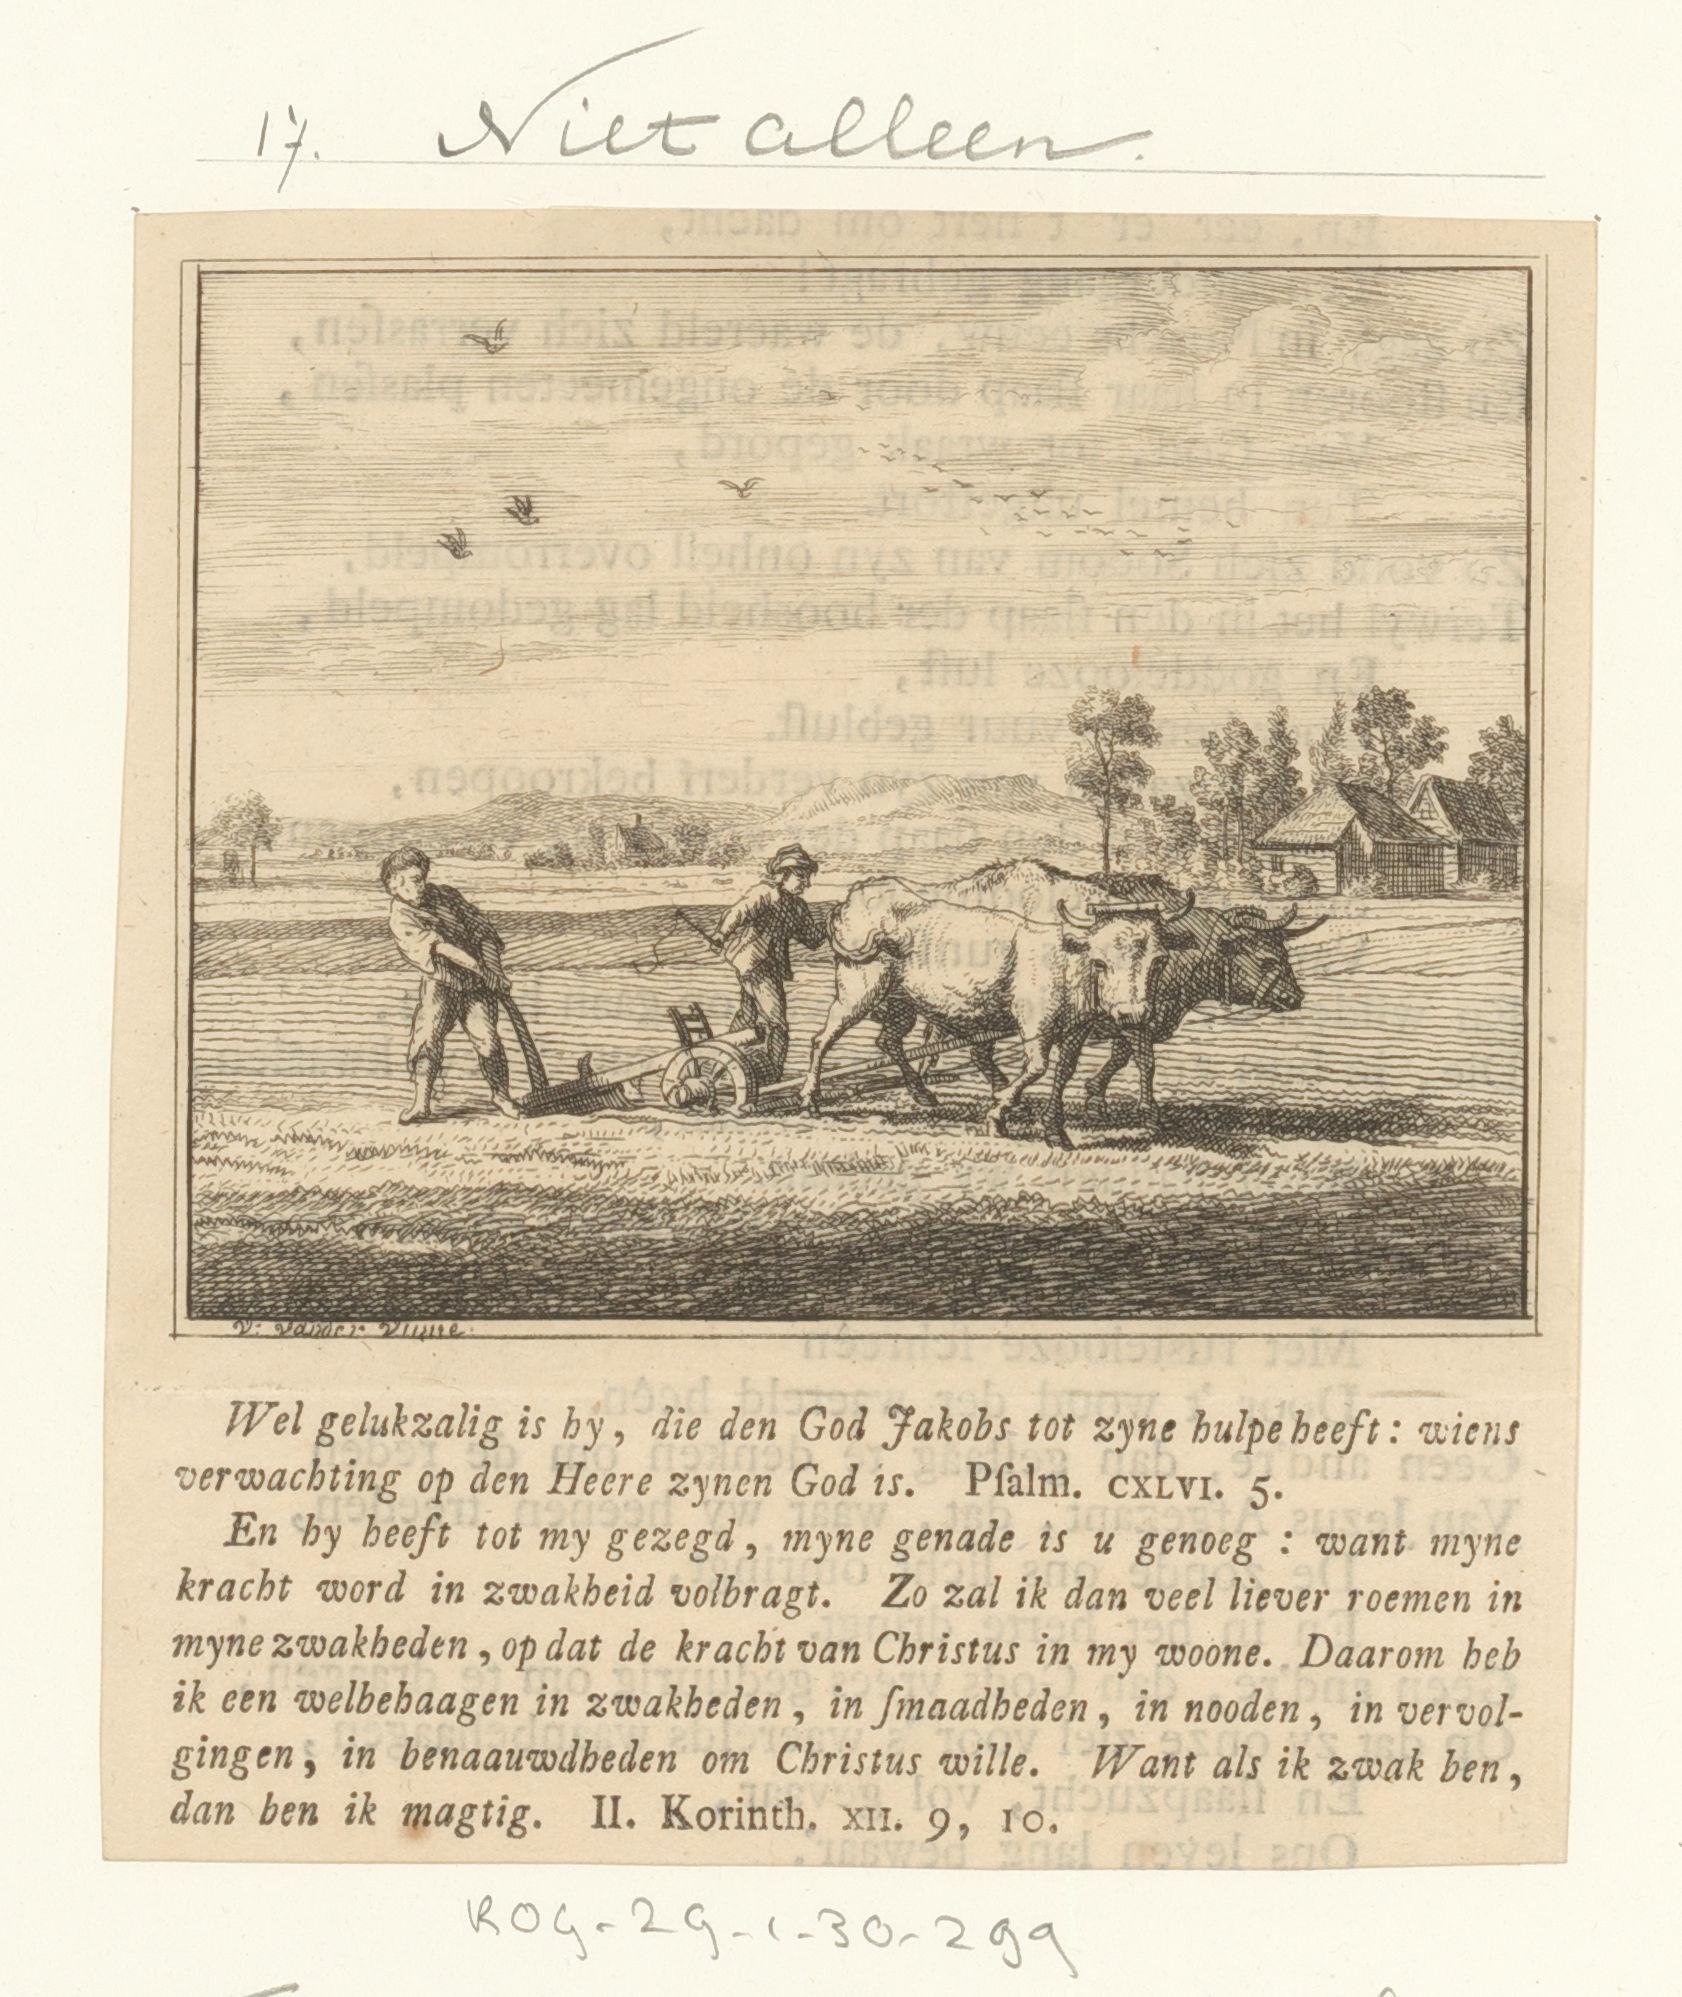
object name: print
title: Twee ossen trekken een ploeg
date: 1758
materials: paper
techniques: etching, letterpress printing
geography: haarlem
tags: proverbs, sayings, etc., agricultural implements: plough, ox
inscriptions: stamp, collector's mark: Lugt 1641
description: Embleem bij het motto: Niet alleen. Onderaan een achtregelige tekst in het Nederlands. Onderwerpsrubrieken binnen de Atlas Zeden en Gewoonten: Zeden en Gewoonten in engeren zin. Volksleven. Zinnebeeldige voorstellingen uit het volkleven op serieprenten. Maanden en diversen (allegorieën).